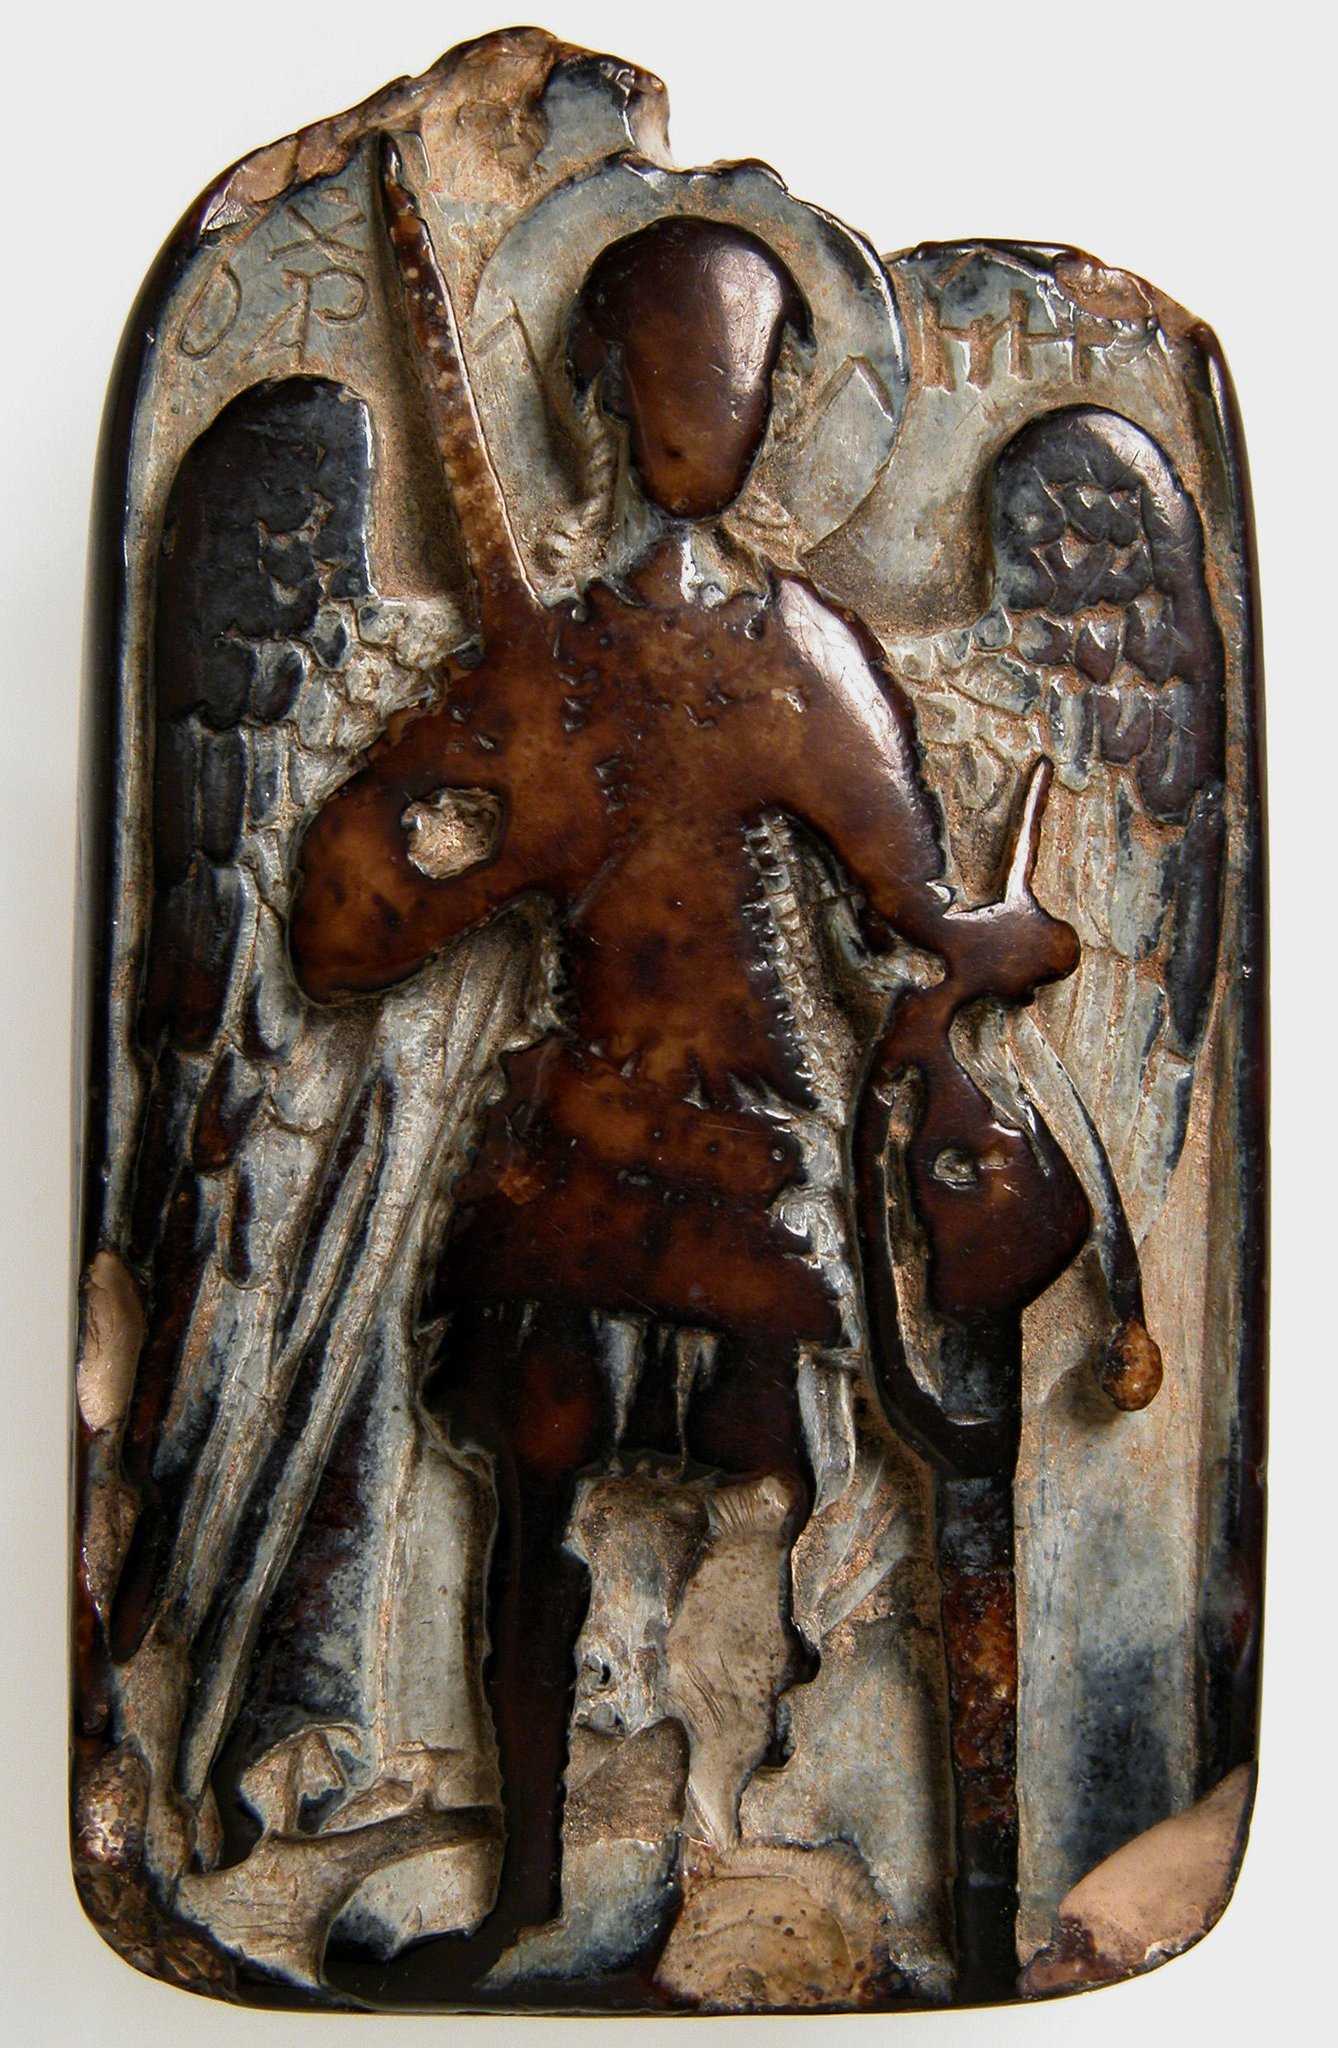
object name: pendant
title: Two-Sided Pendant with the Archangel Michael and Daniel in the Lion’s Den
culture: byzantine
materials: stone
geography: probably constantinople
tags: men,lions,angels